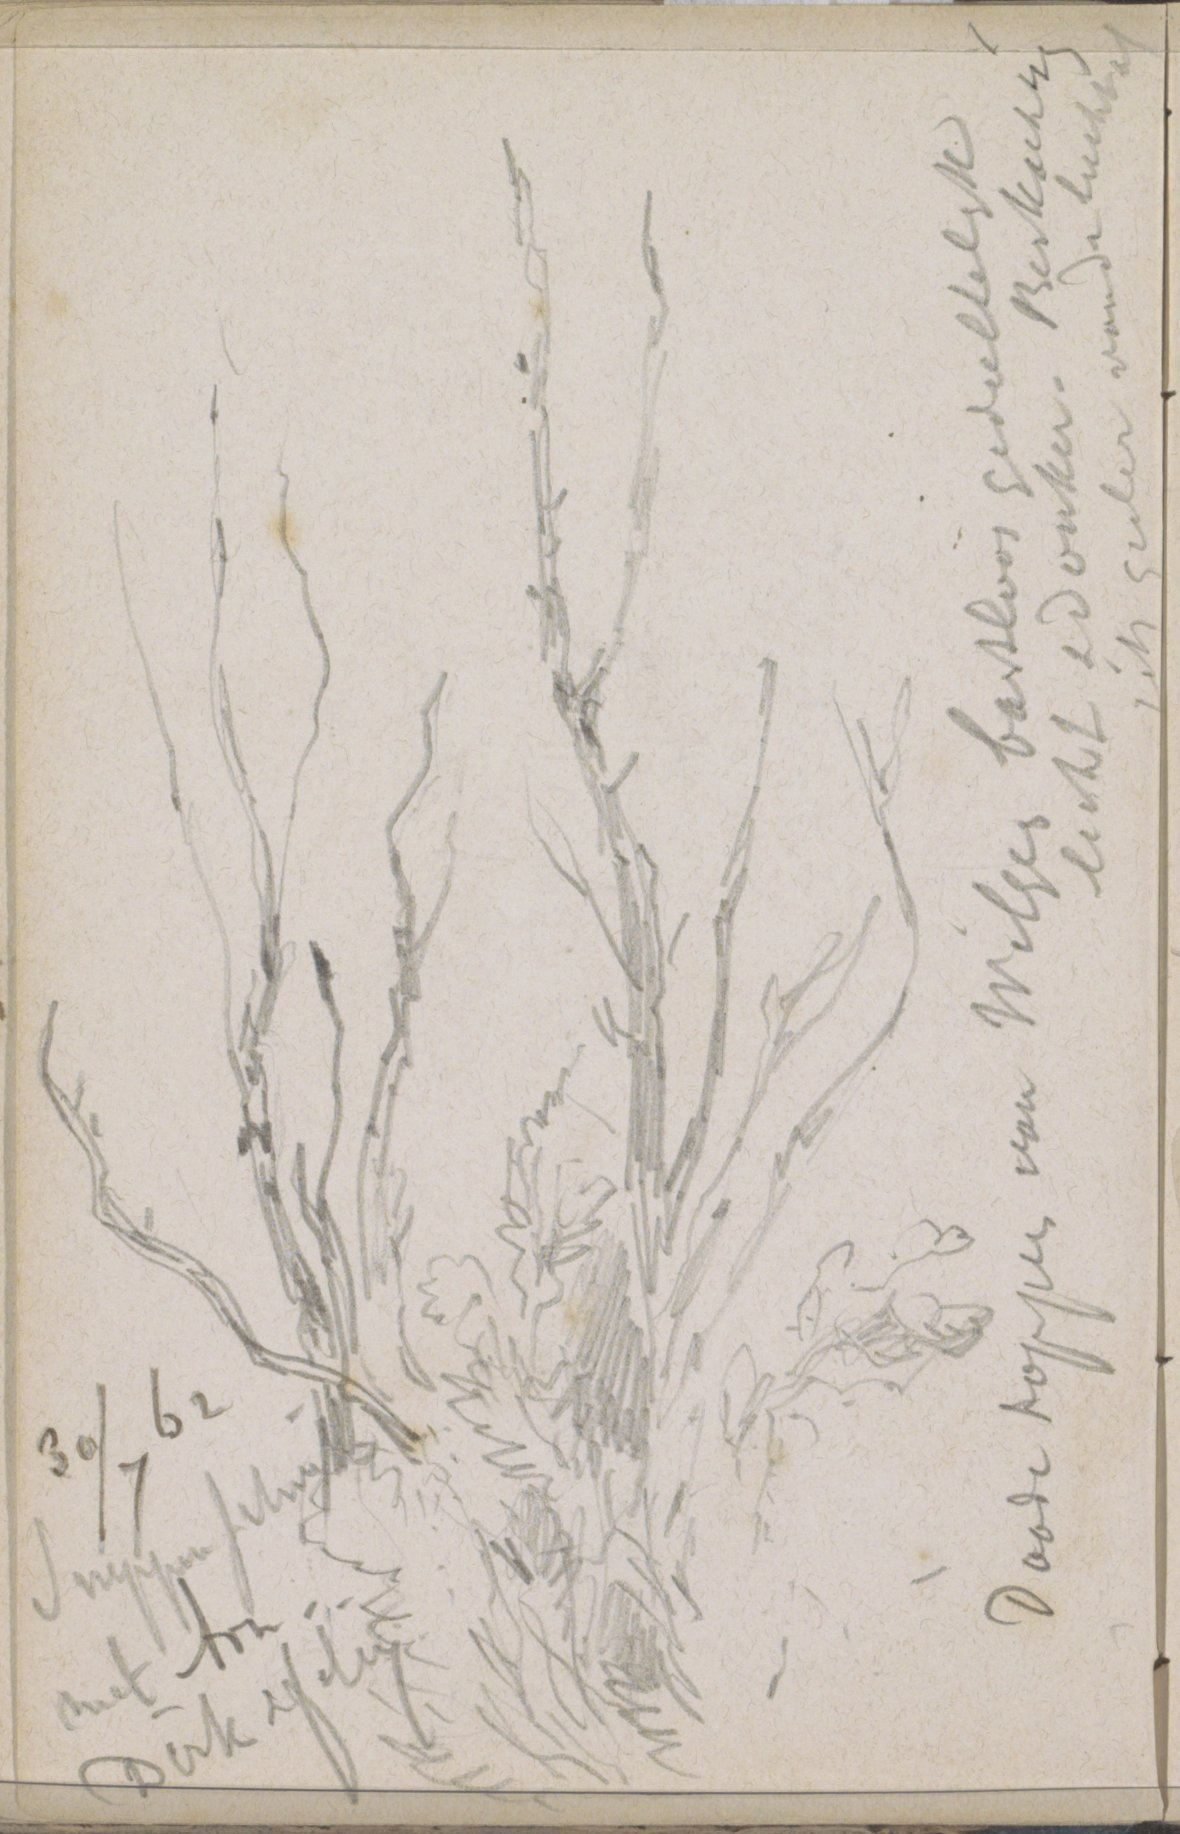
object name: sketchbook leaf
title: Planten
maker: johannes tavenraat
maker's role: draughtsman, painter, print maker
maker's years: 1809-1881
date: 1807-1862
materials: paper, pencil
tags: plants (in general)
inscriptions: date: ‘30/7 62’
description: Blad 25 verso uit een schetsboek met 65 bladen.